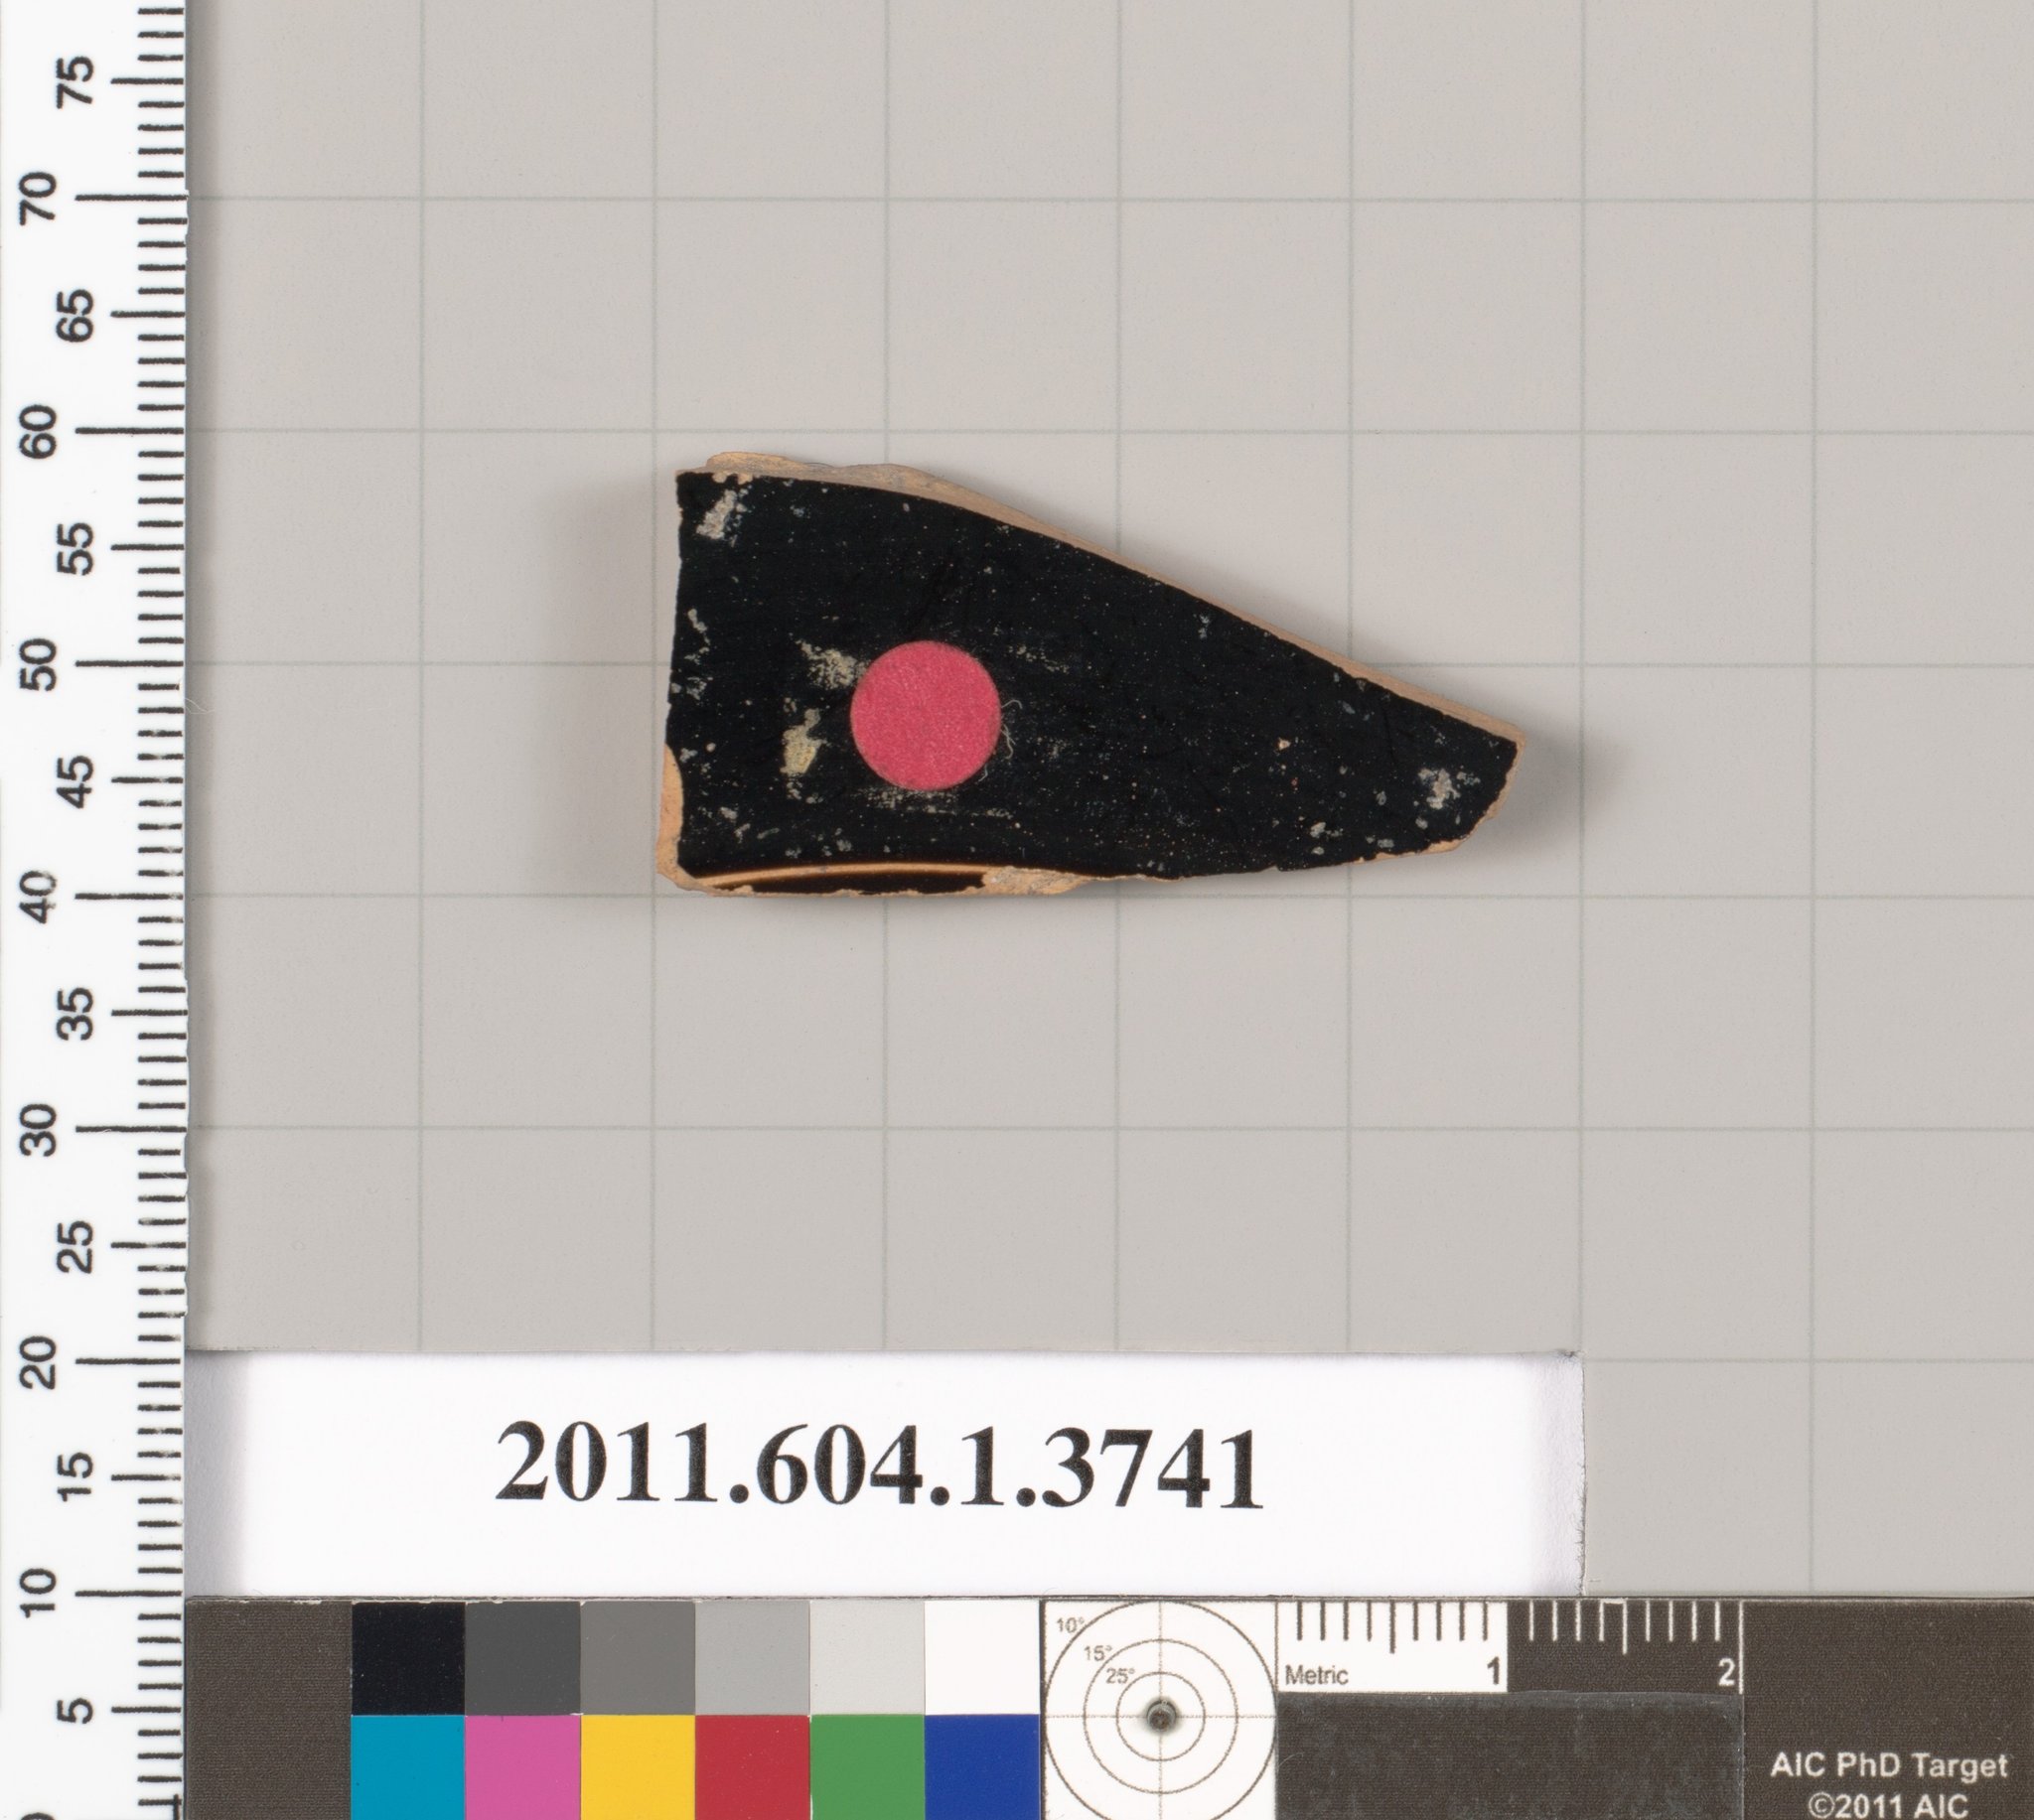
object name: kylix fragment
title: Terracotta fragment of a kylix (drinking cup)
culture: greek, attic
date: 475-451 BCE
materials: terracotta